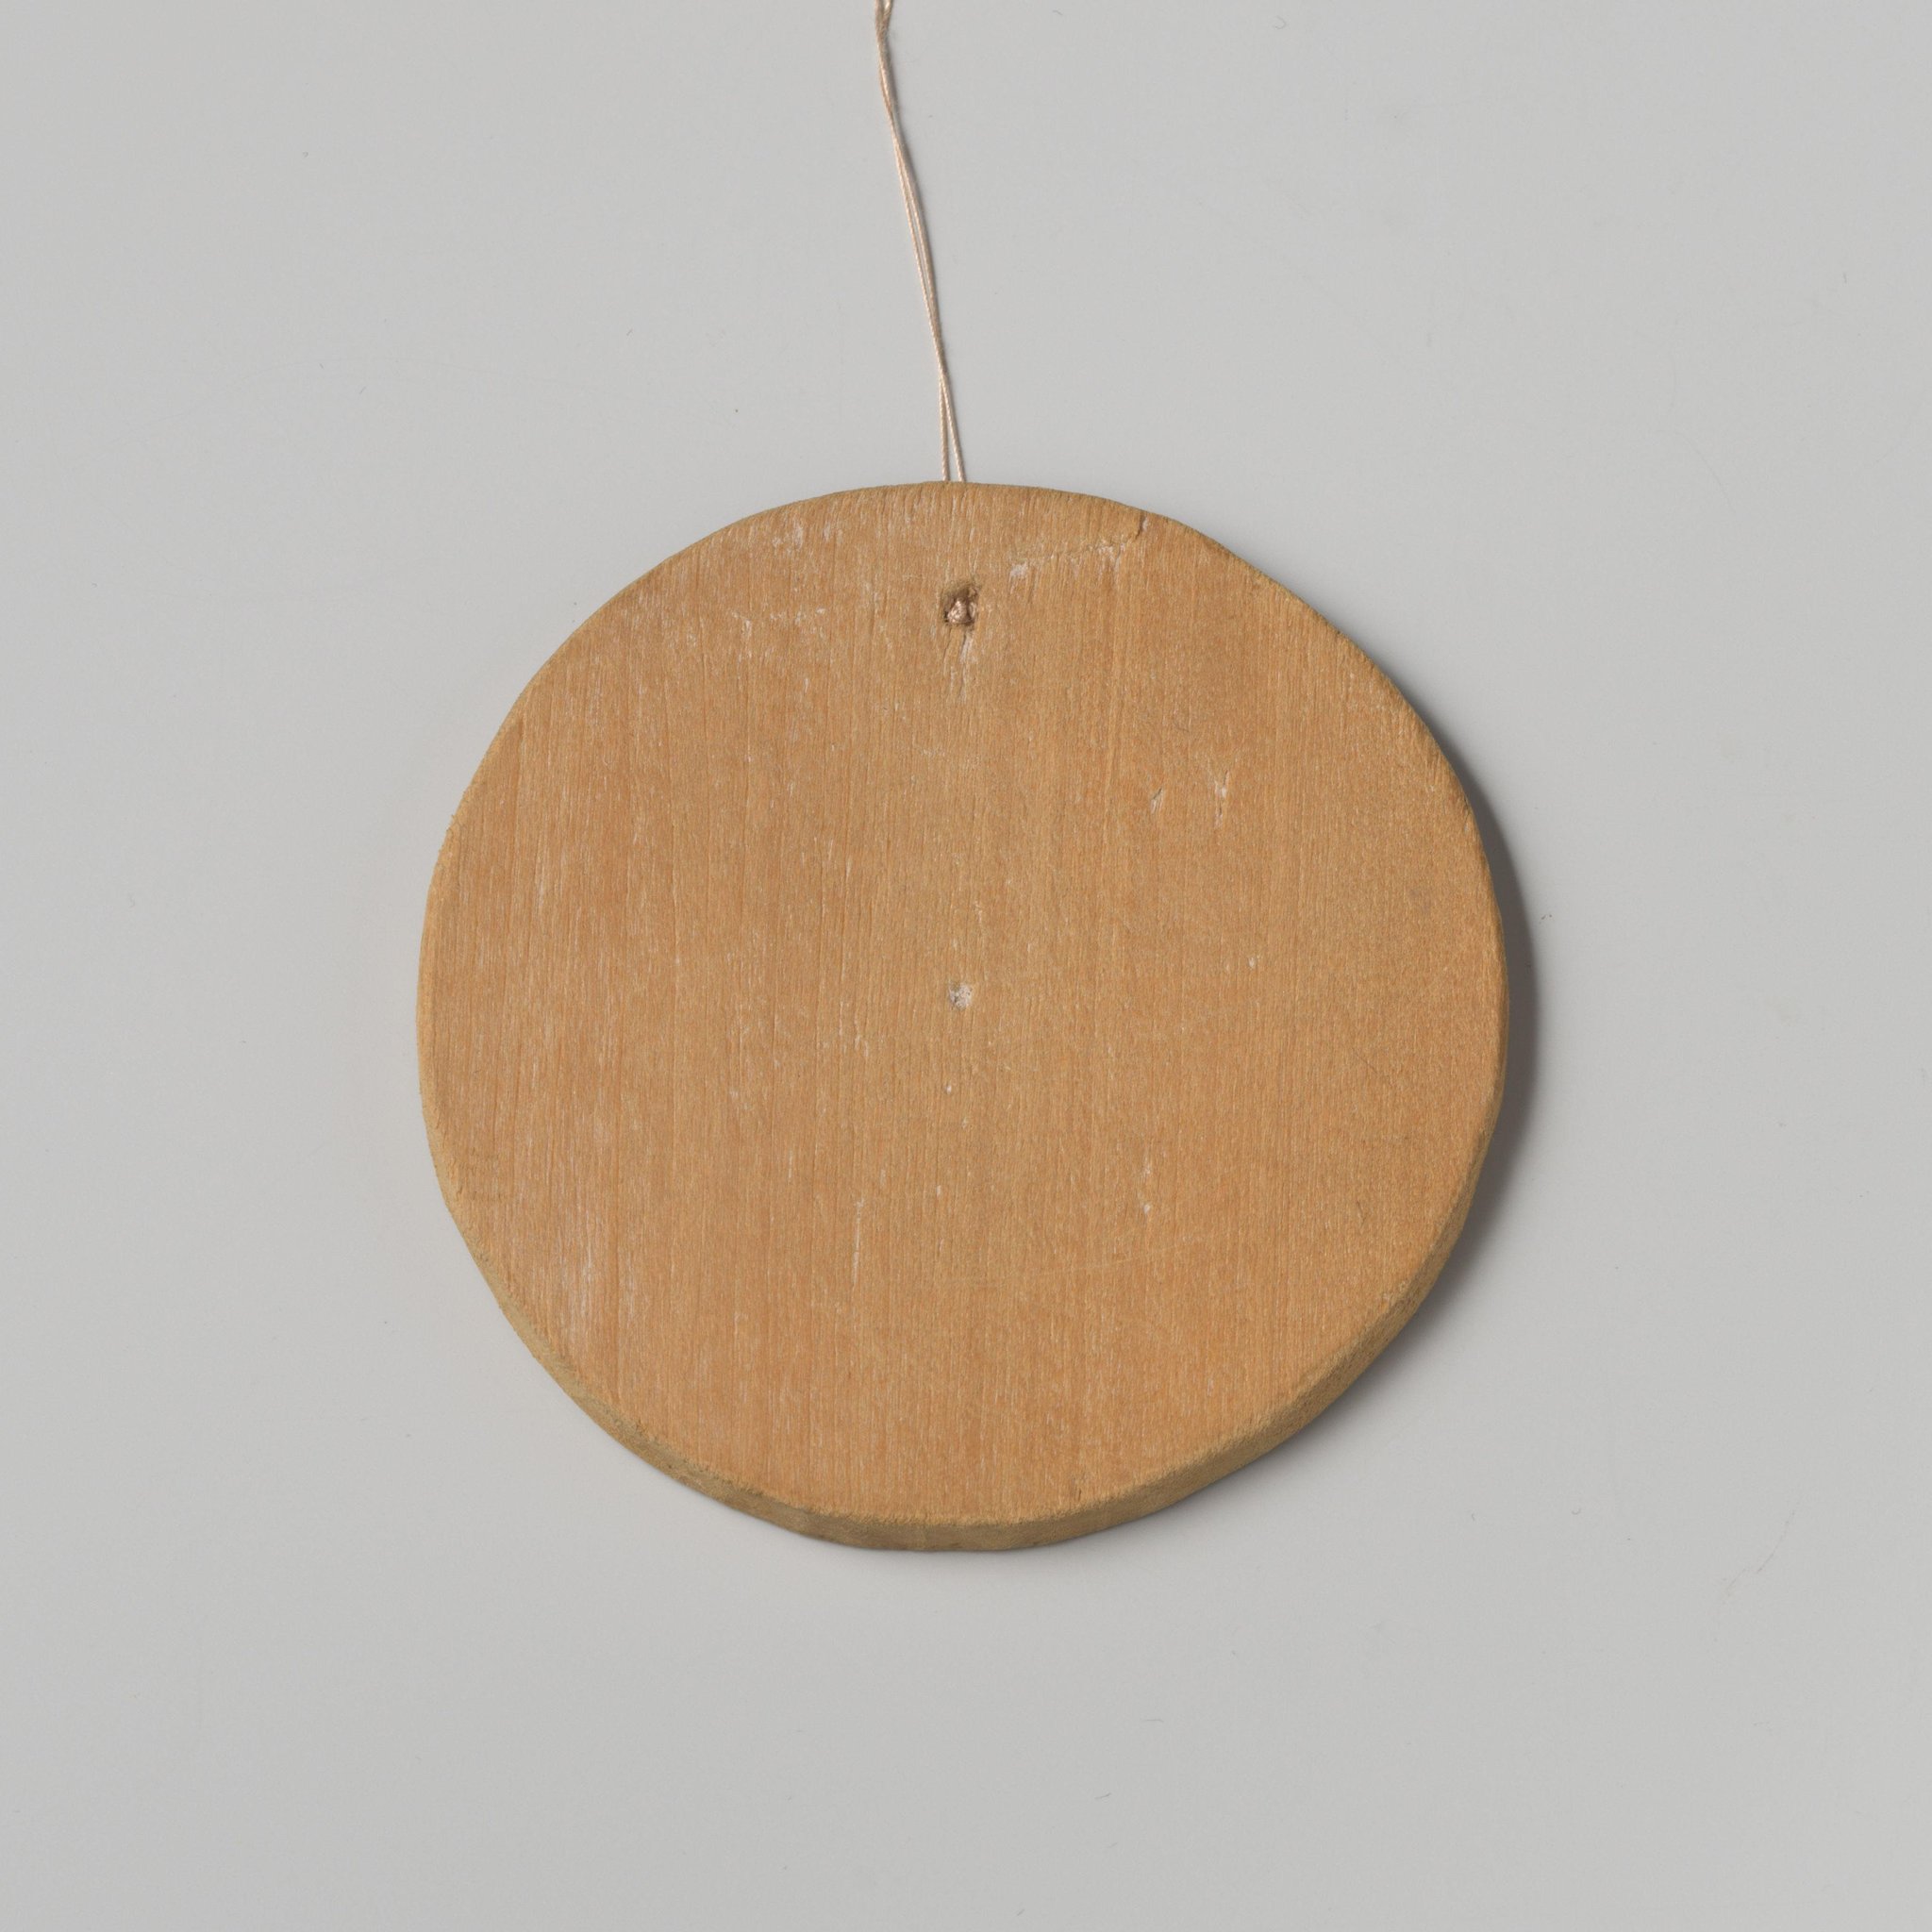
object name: pastry board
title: Deegplank van without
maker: Anonymous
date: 1675-1699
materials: without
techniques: without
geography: amsterdam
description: Deegplank of taartplank van without, rond van vorm.